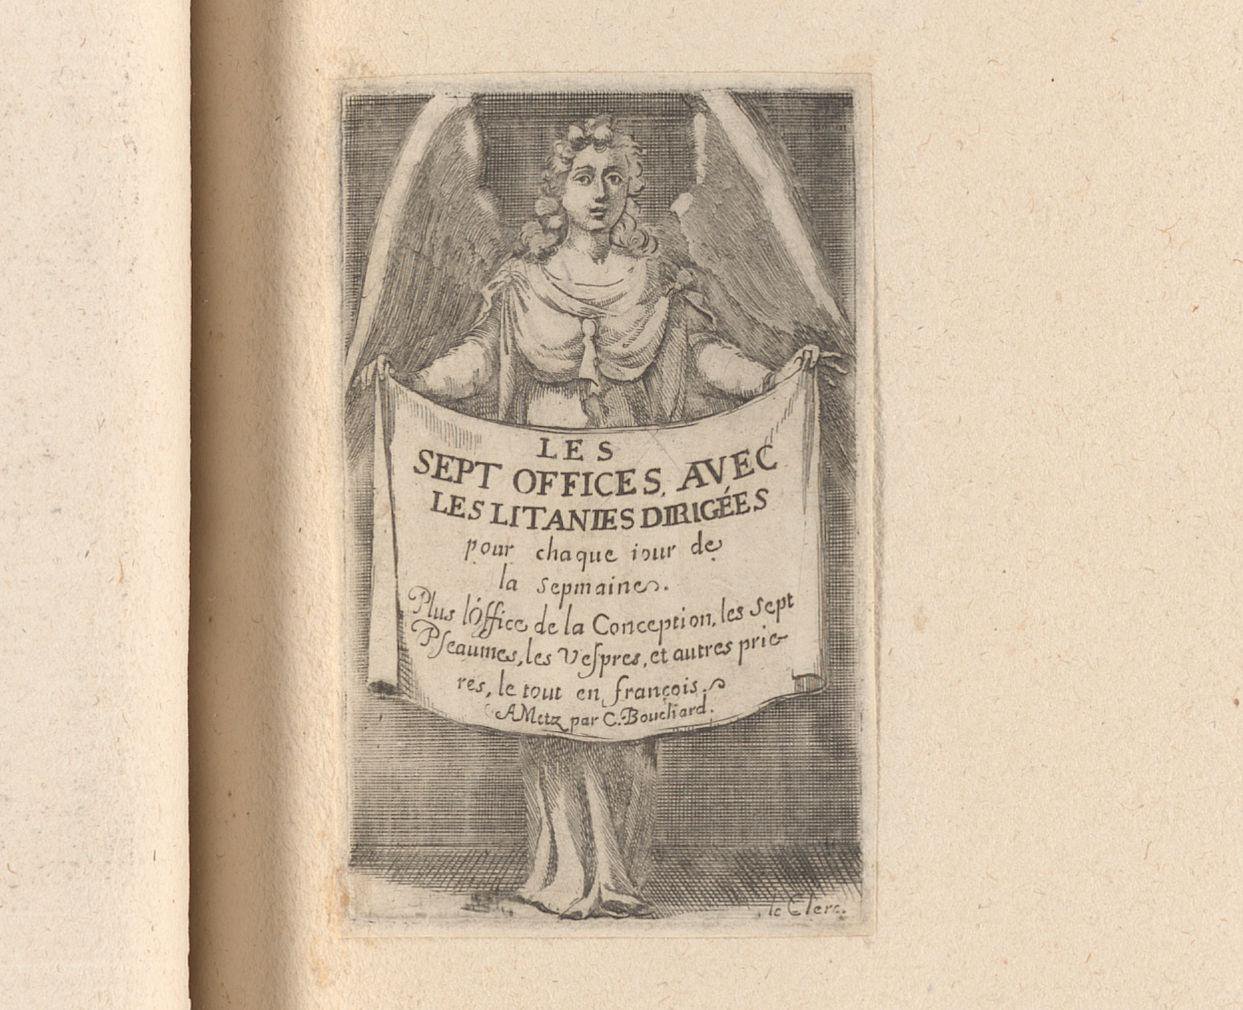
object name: titelprent, frontispice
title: Titelprent van een gebedenboek met engel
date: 1654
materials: paper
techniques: etching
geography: metz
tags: angels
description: Dit betreft een prent uit een gebedenboek met de titel 'Les Sept Offices avec les Litanies Dirigées (...)'.